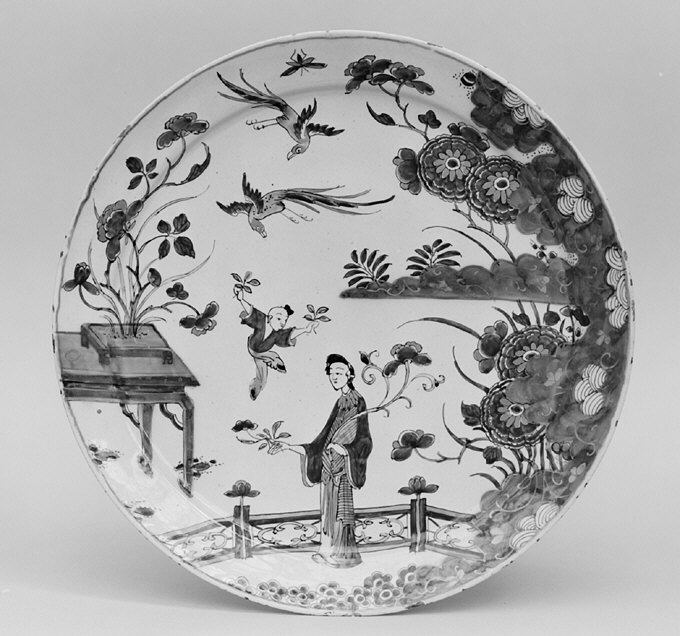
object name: plate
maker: pieter adriaeusz kocks and his widow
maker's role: maker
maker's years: 1701-1722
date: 1700-1725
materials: earthenware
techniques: glazing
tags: human figures,birds,flowers